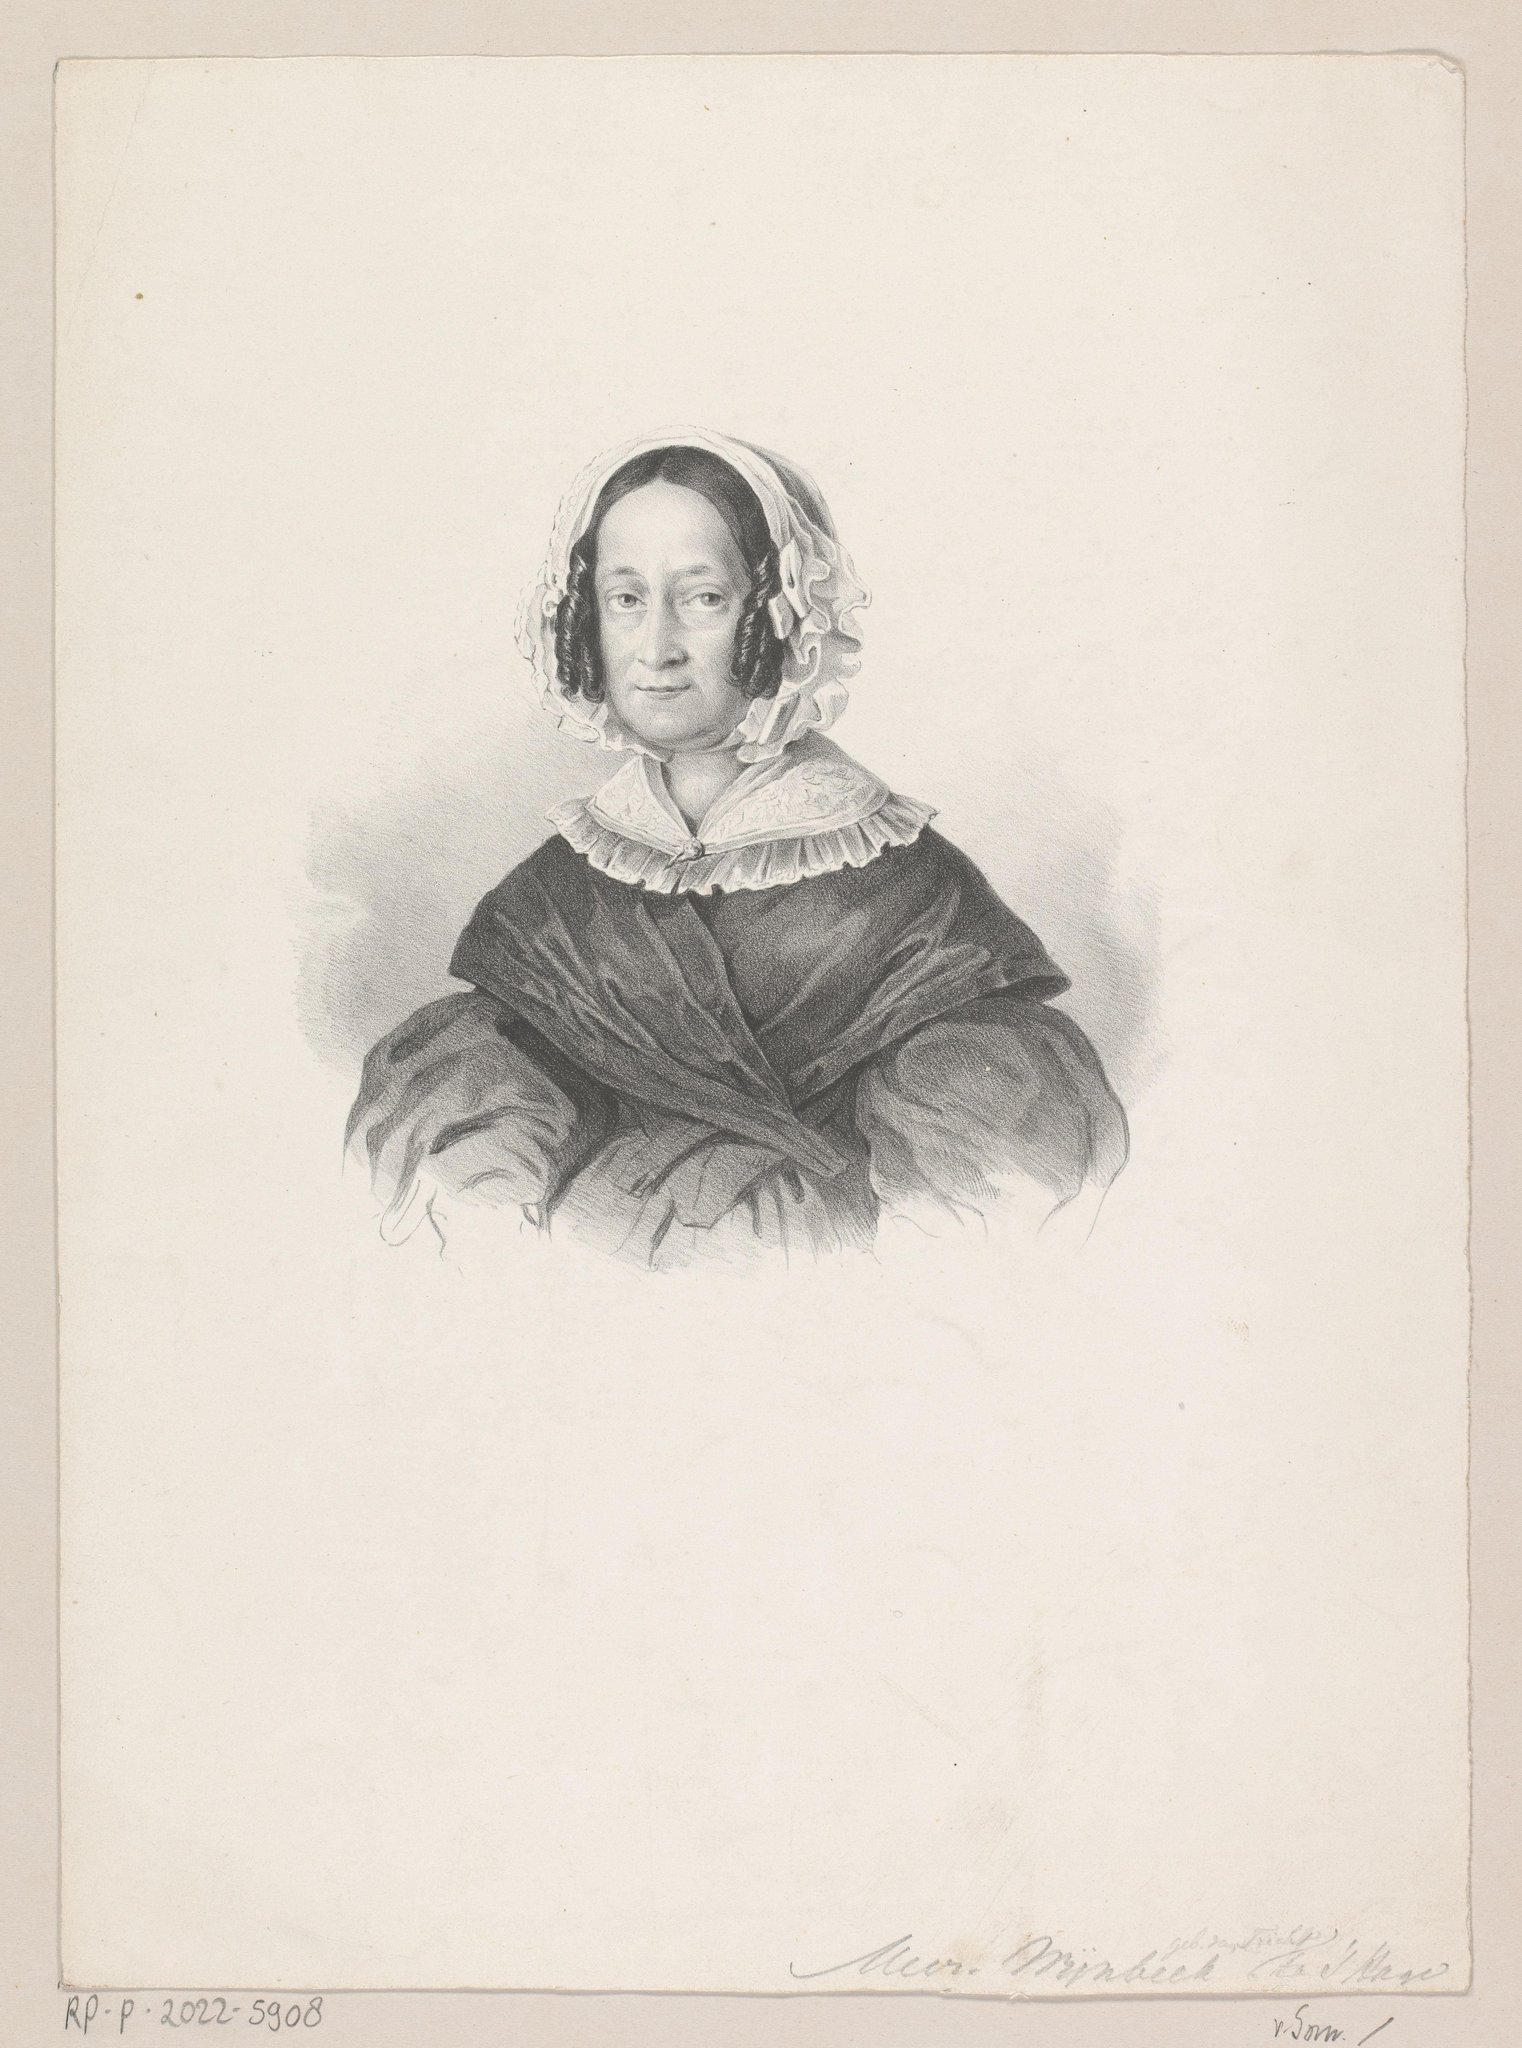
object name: print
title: Portret van Maria Elisabeth Wijnbeek van Tricht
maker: Anonymous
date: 1837-1849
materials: paper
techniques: lithograph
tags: historical persons